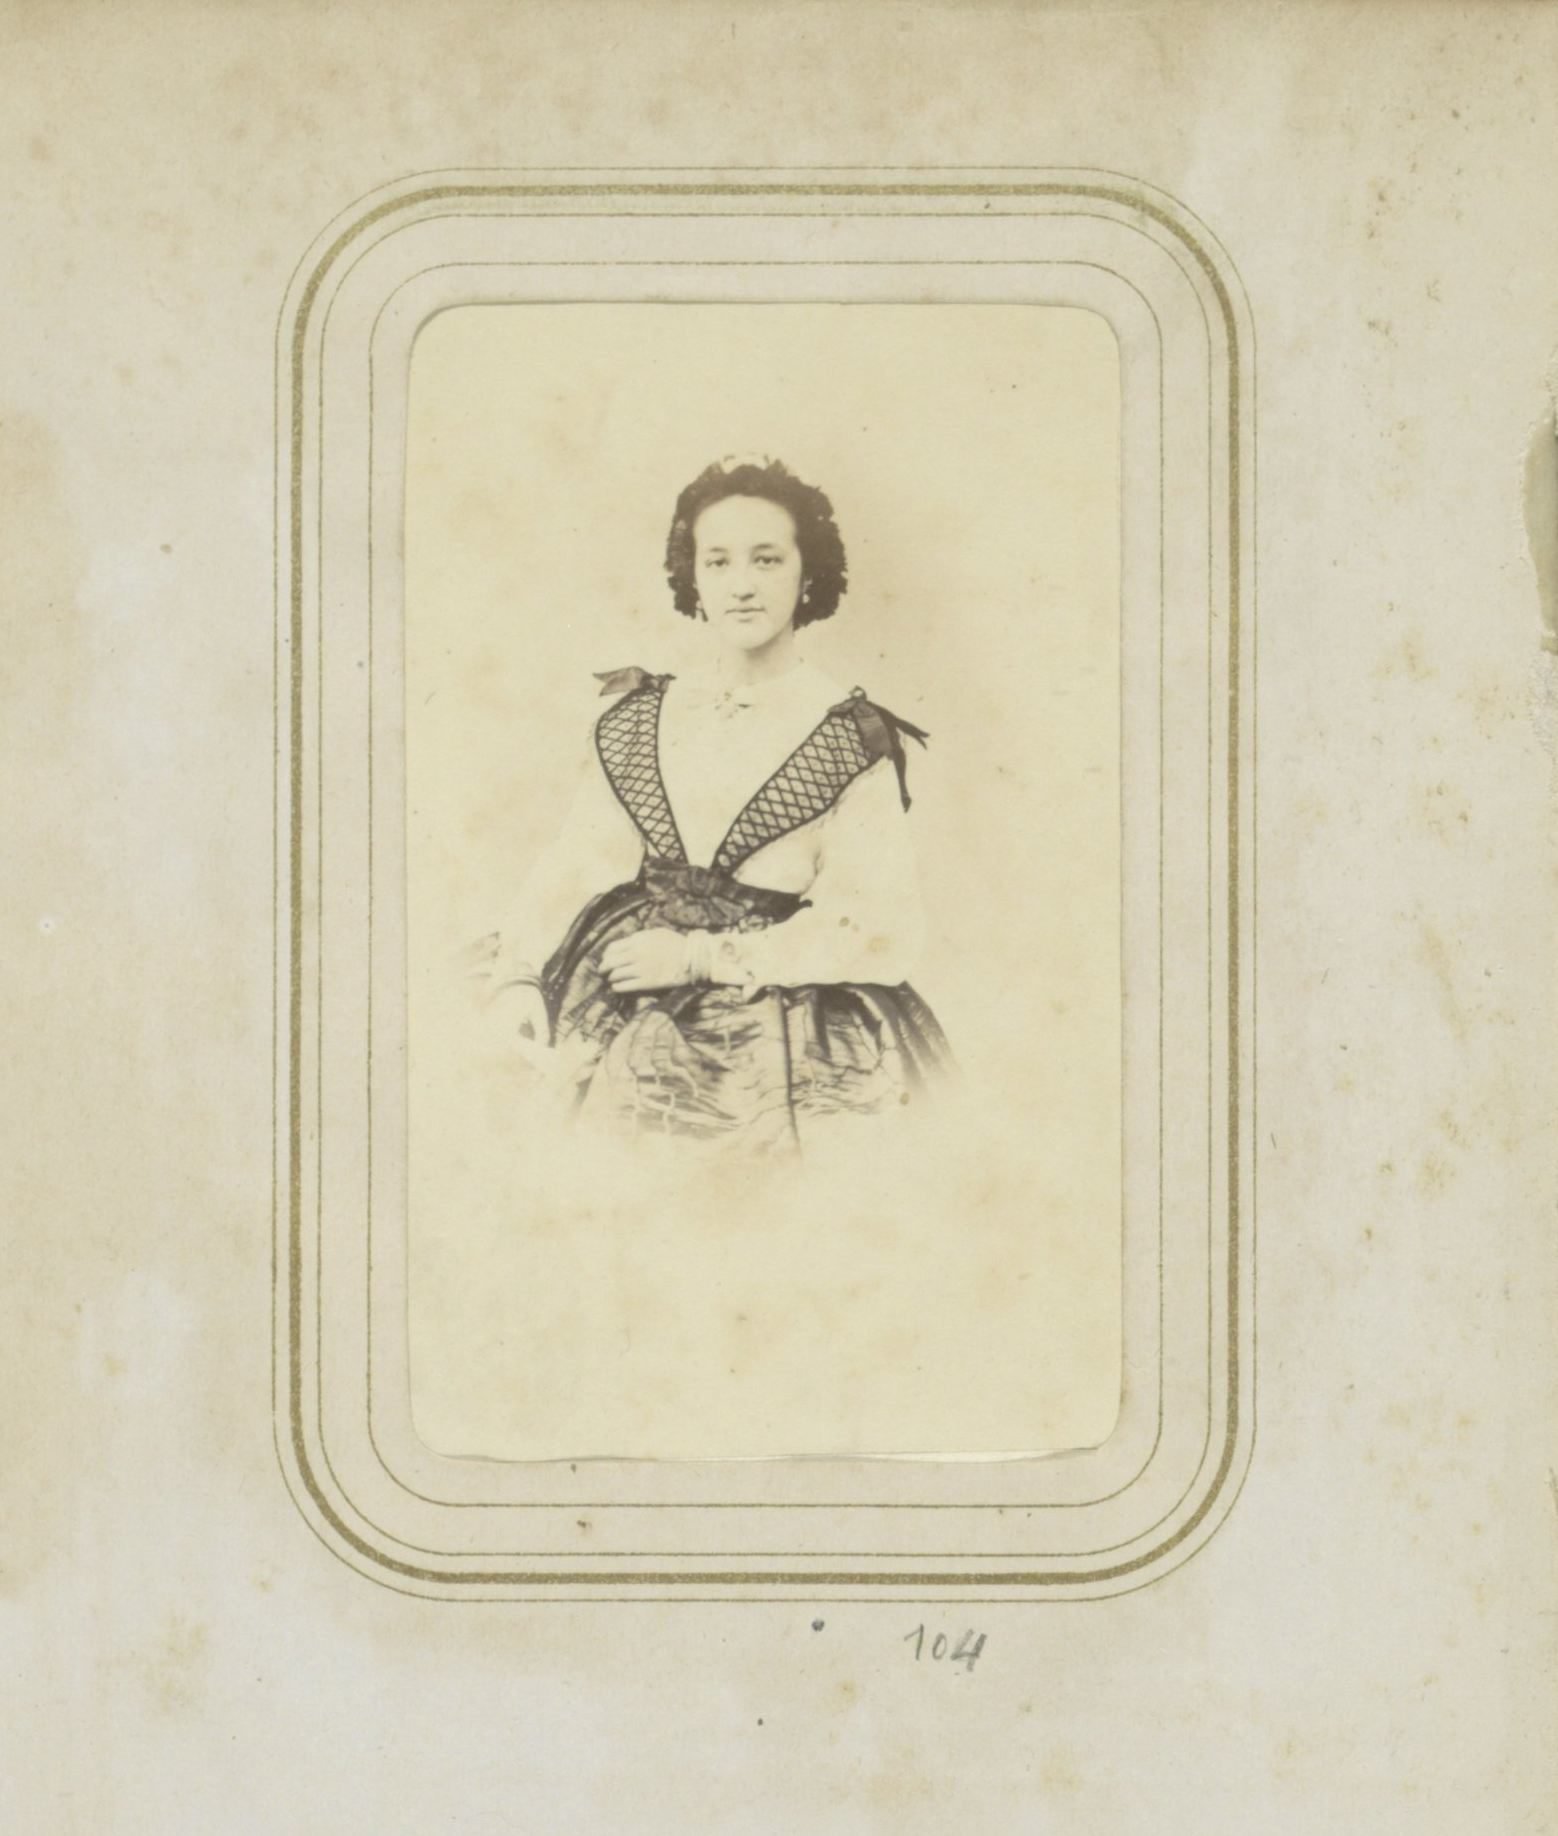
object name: carte de visite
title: Portret van een vrouw in een wijde rok met een witte blouse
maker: c. perret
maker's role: fotograaf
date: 1870-1885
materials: cardboard, photographic support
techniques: albumen print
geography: java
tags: head-gear, clothing for the upper part of the body: blouse (+ women's clothes), historical persons, styles of hairdress - aa - ~ women, skirt, family, relationship, descent, ear-rings, java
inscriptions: address: ‘Java’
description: Onderdeel van Familiealbum van H.W.F. Ligtenberg en L.M. Swart met 149 foto's en cartes-de-visite.